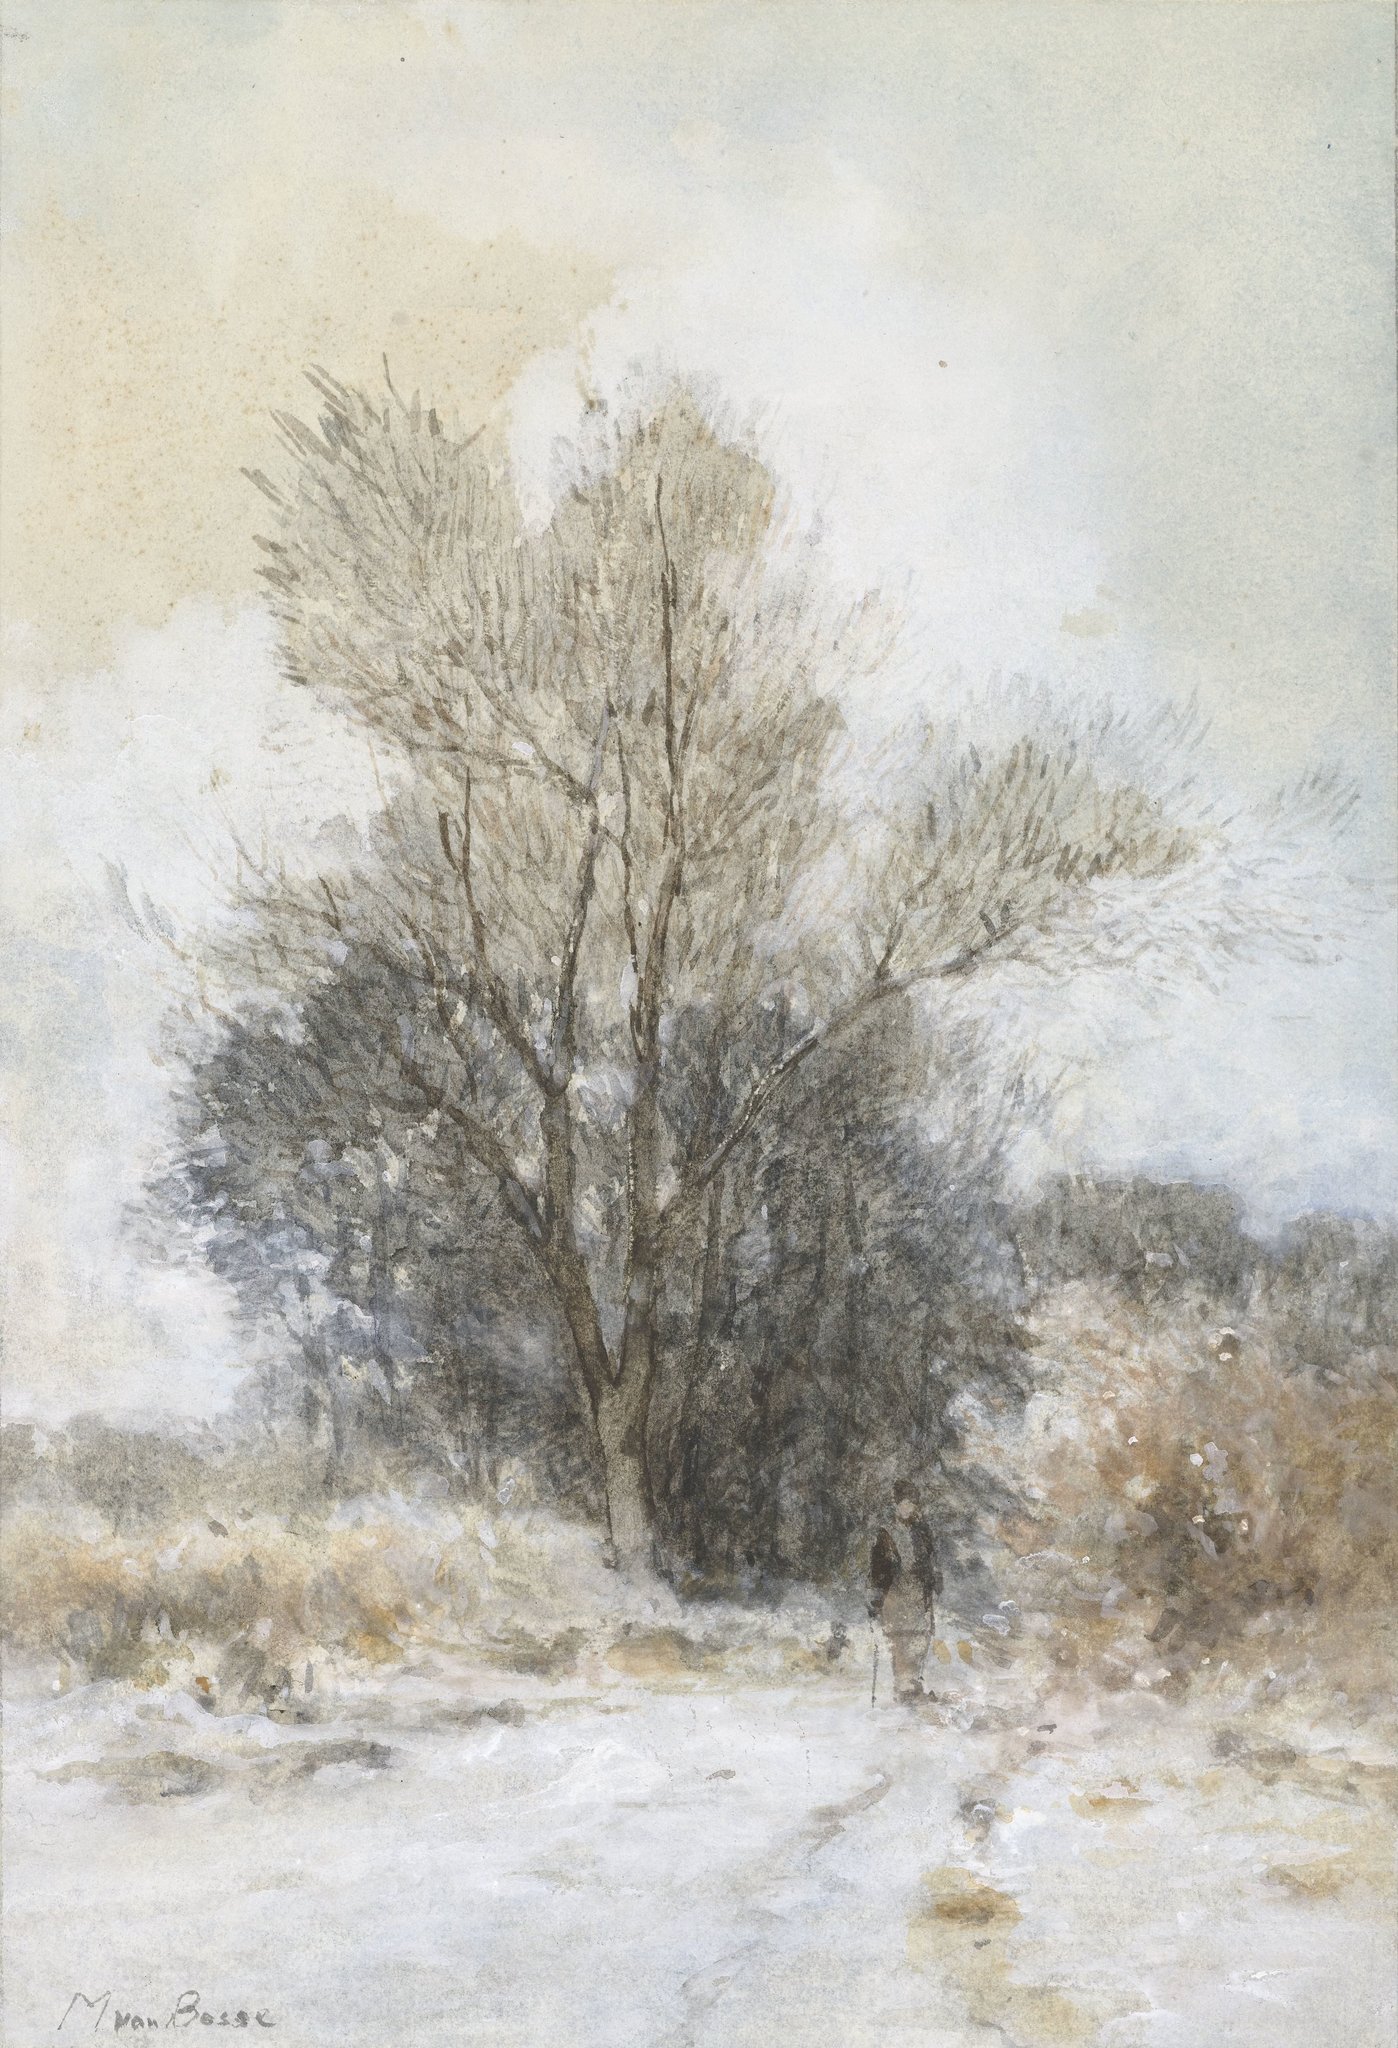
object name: drawing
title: Wandelaar in de sneeuw bij de rand van een bos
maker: maria bilders-van bosse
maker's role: draughtsman, painter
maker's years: 1837-1900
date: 1847-1900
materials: chalk, paint, paper, watercolor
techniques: brush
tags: snow